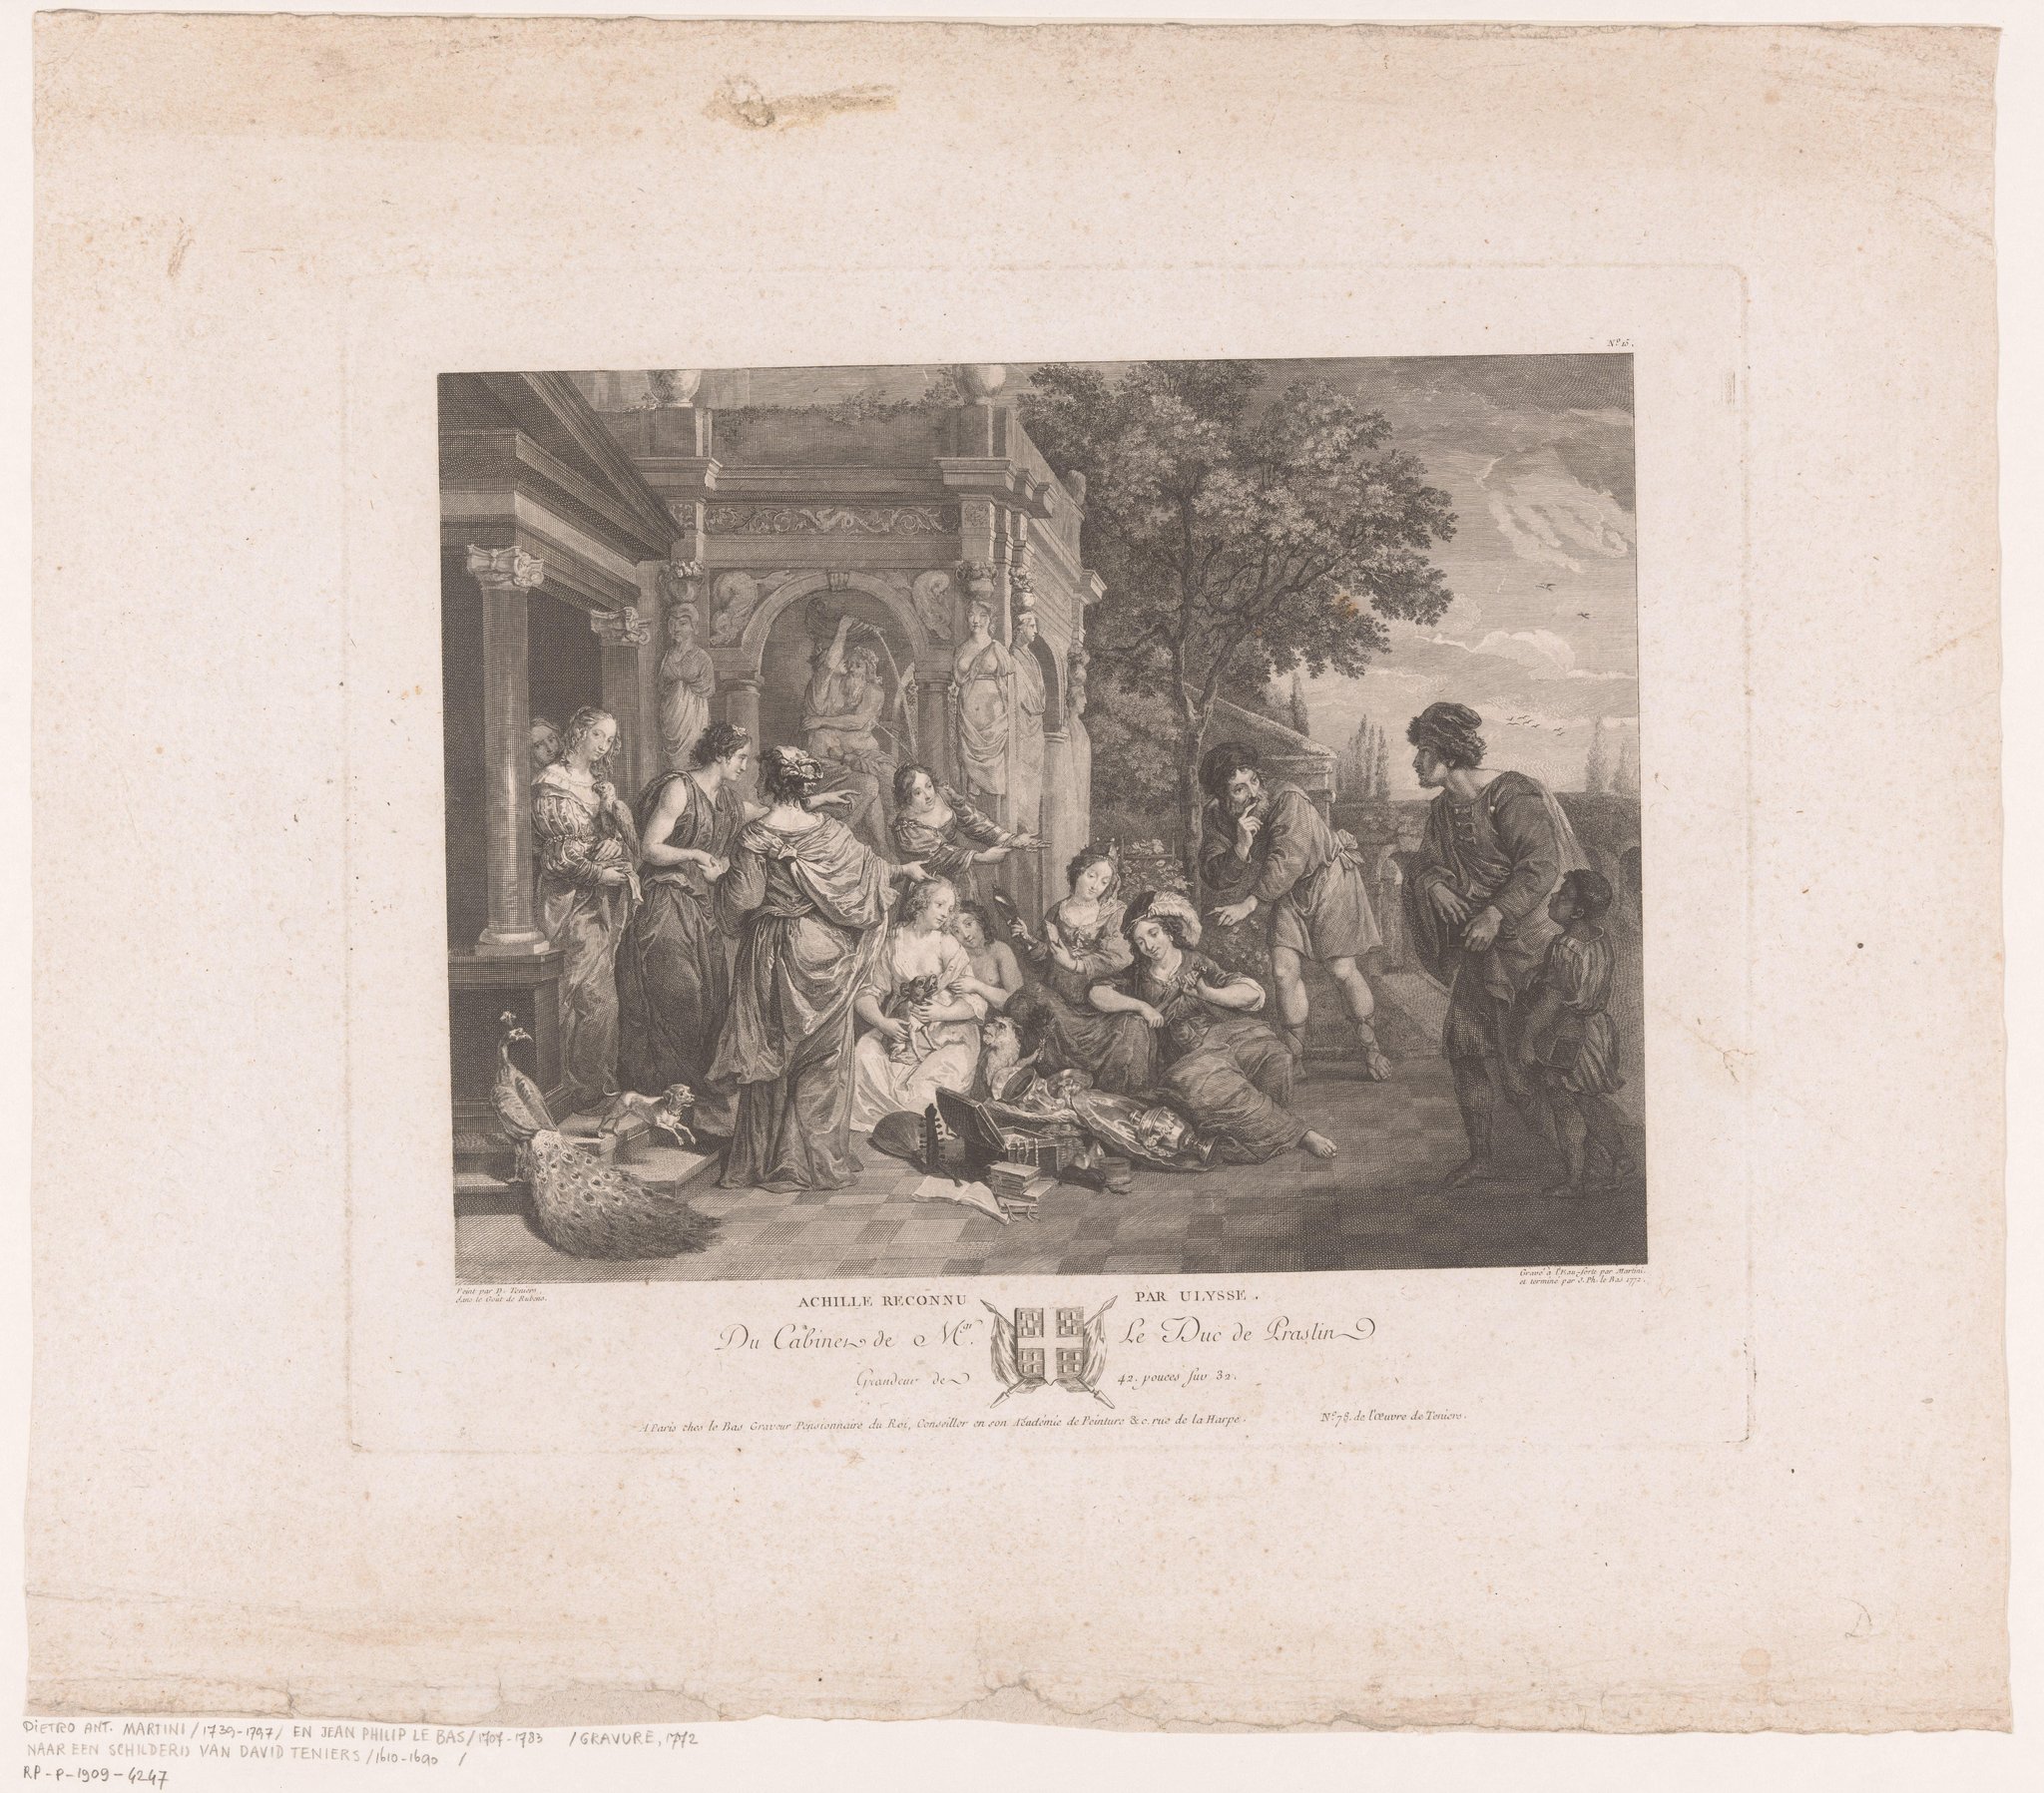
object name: print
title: Achilles wordt herkend door Odysseus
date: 1772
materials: paper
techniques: engraving, etching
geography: paris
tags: africans, achilles discovered among the daughters of lycomedes, i.e. achilles on scyros: when presents are brought achilles snatches up the weapons and thus betrays his identity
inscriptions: collector's mark: Lugt 2228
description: Achilles wordt ontdekt tussen de dochters van Lycomedes. Het gezelschap zit voor een antiek gebouw. Rechtsvoor een zwarte bediende met een kist. Genummerd rechtsboven: No. 15; rechtsonder: No. 78 de l'Oeuvre de Teniers.